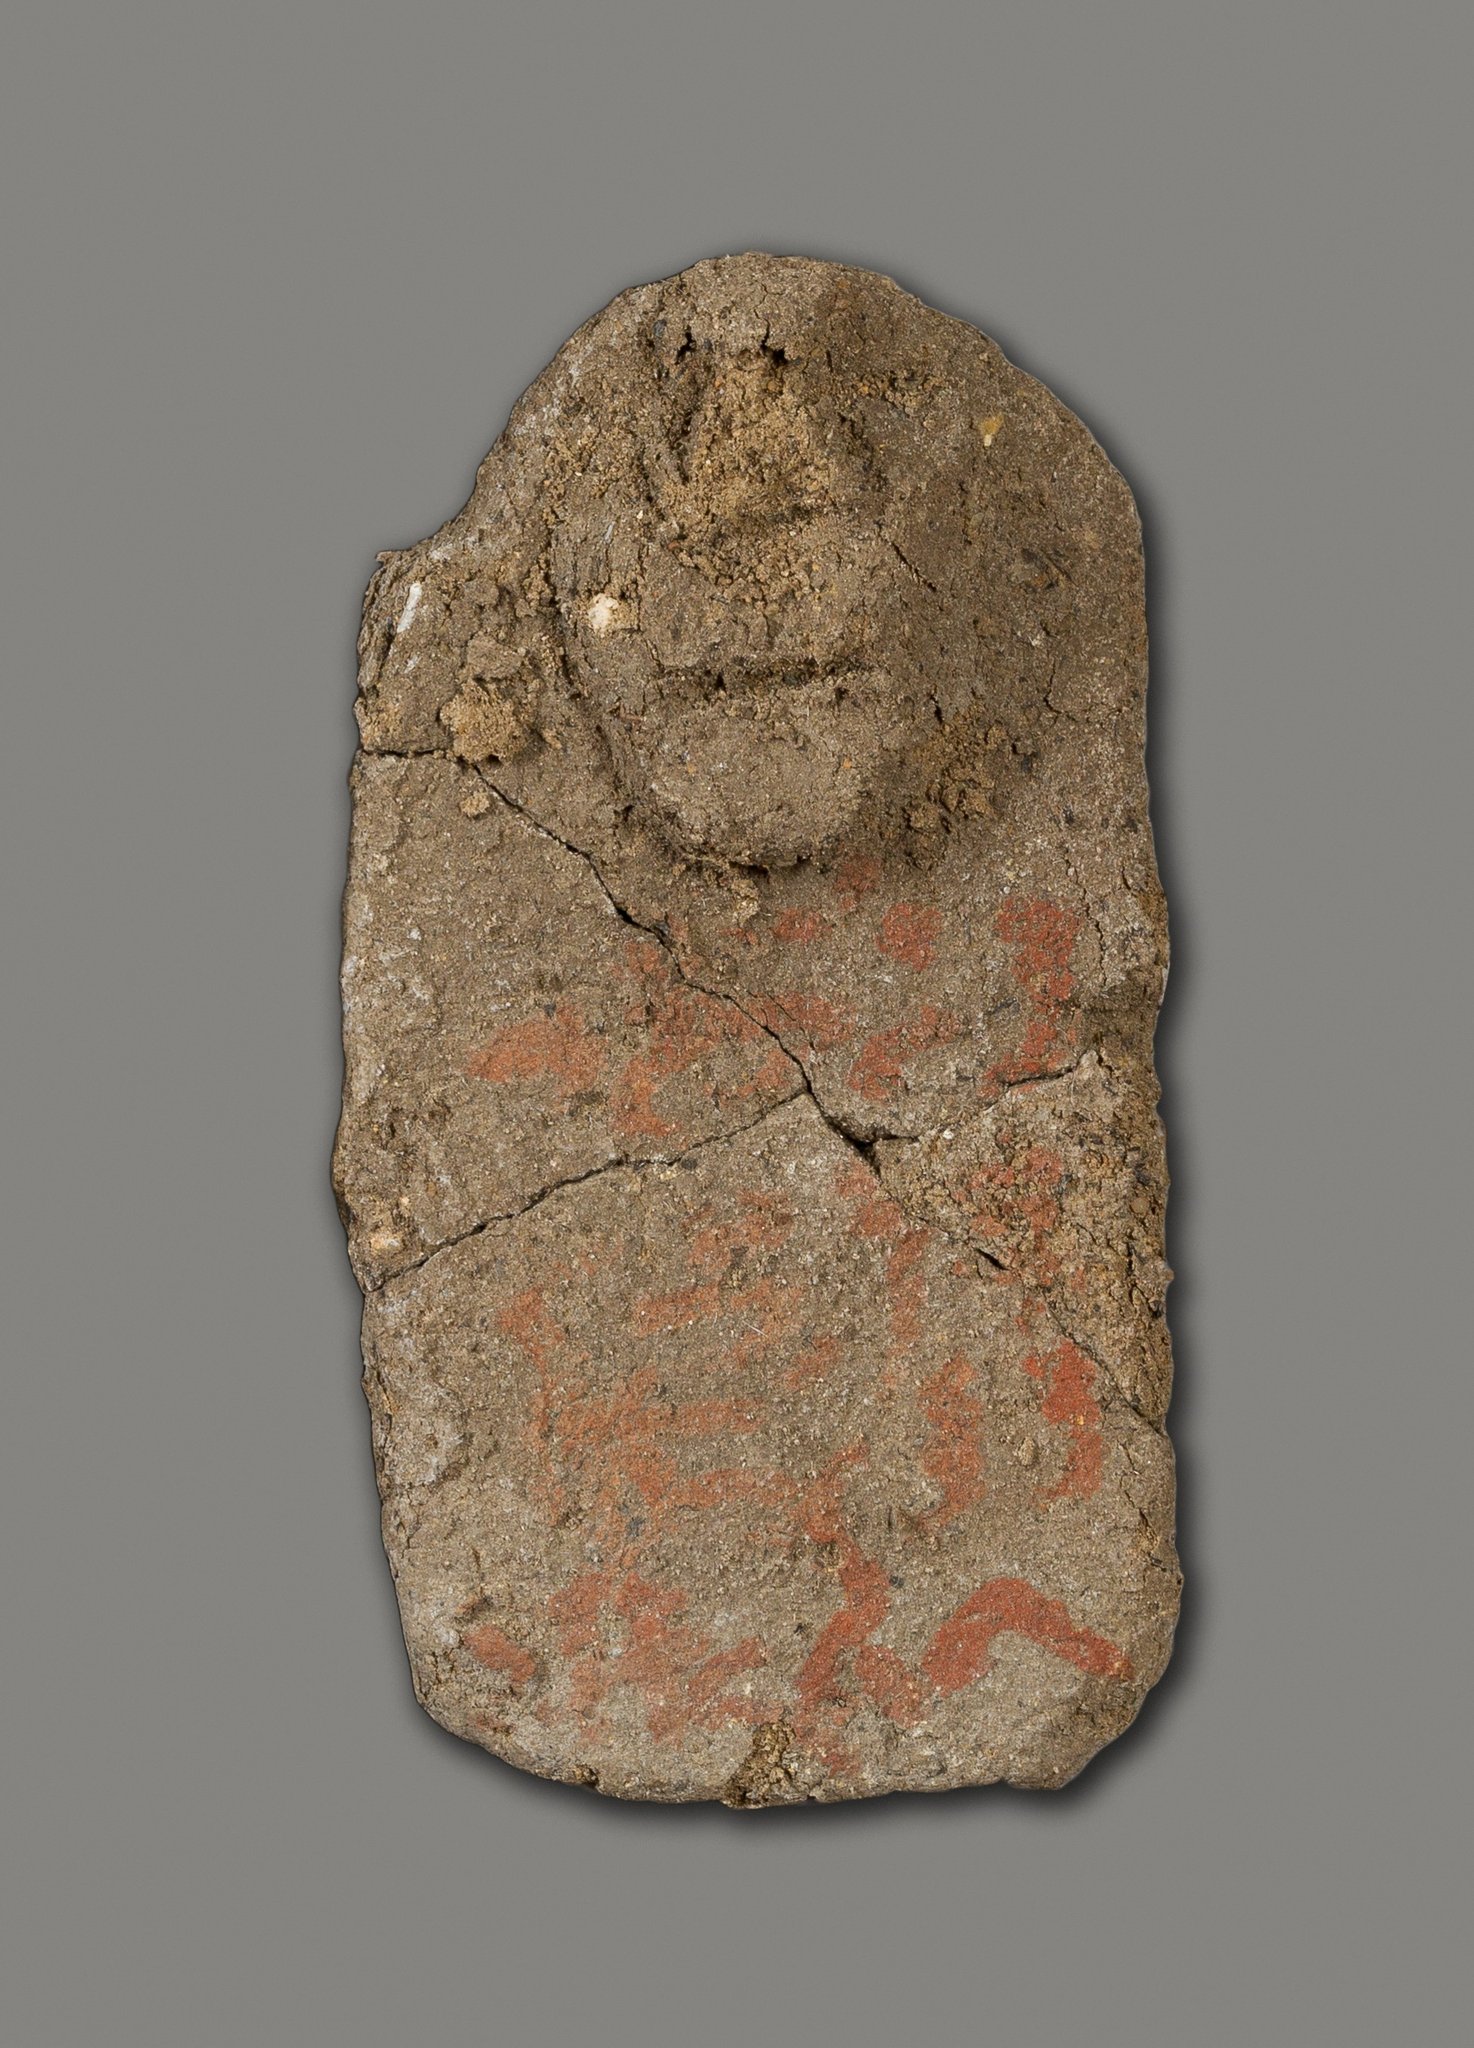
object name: figure, magical, execration, tablet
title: Magical Figure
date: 1802-1550 BCE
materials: clay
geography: egypt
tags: faces